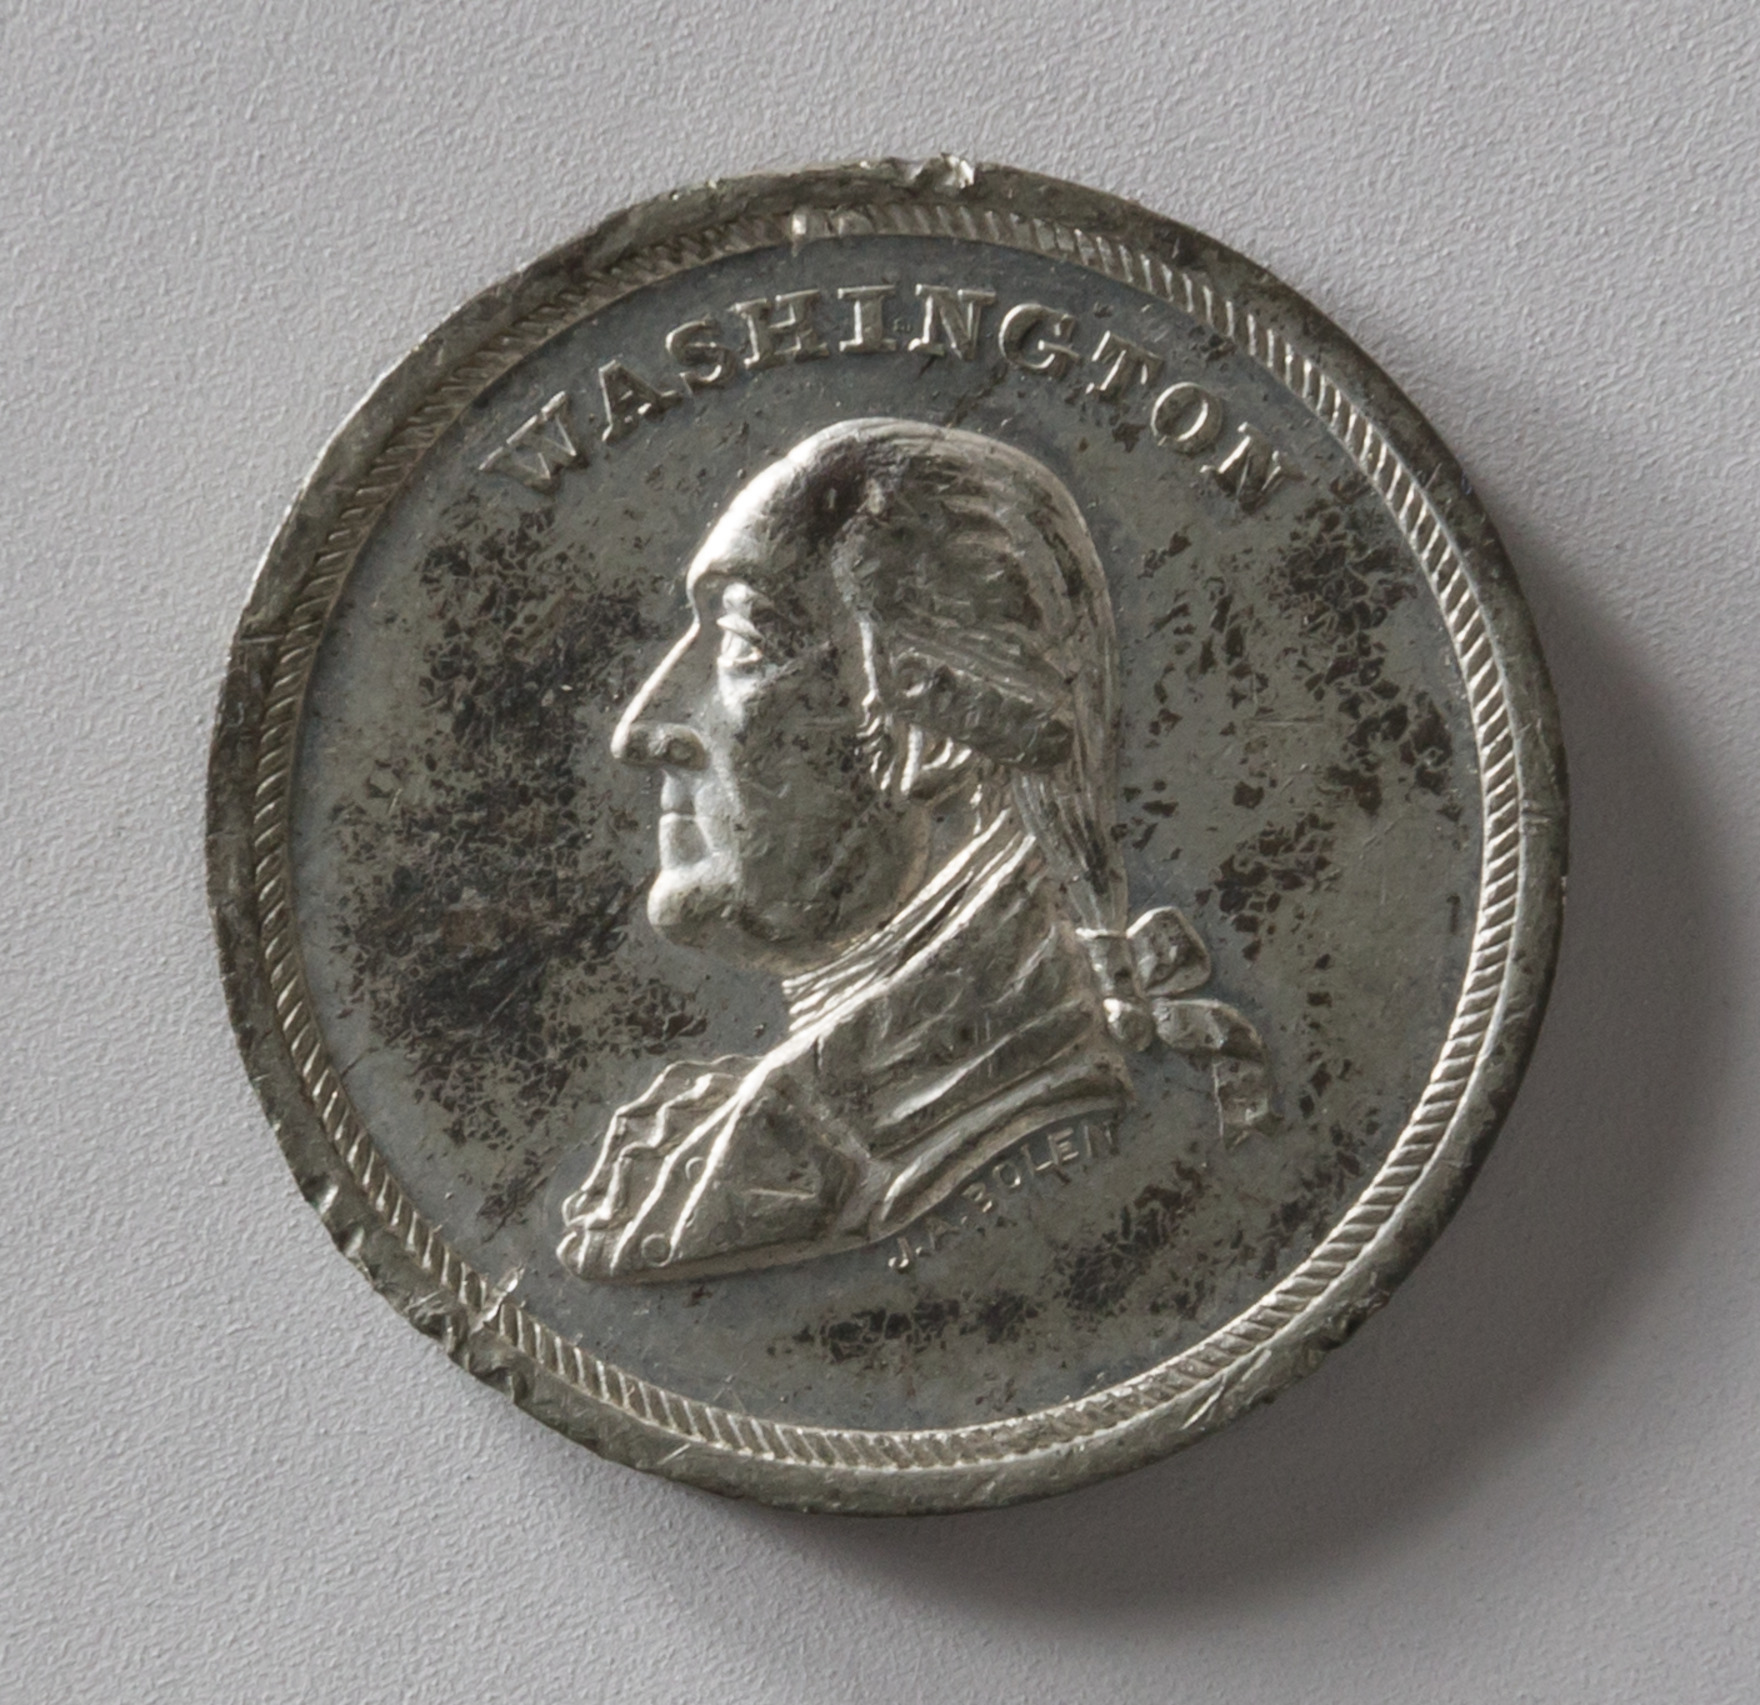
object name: medal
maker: john a. bolen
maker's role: maker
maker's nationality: american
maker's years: 1826-1906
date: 1864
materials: metal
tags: george washington,portraits,profiles